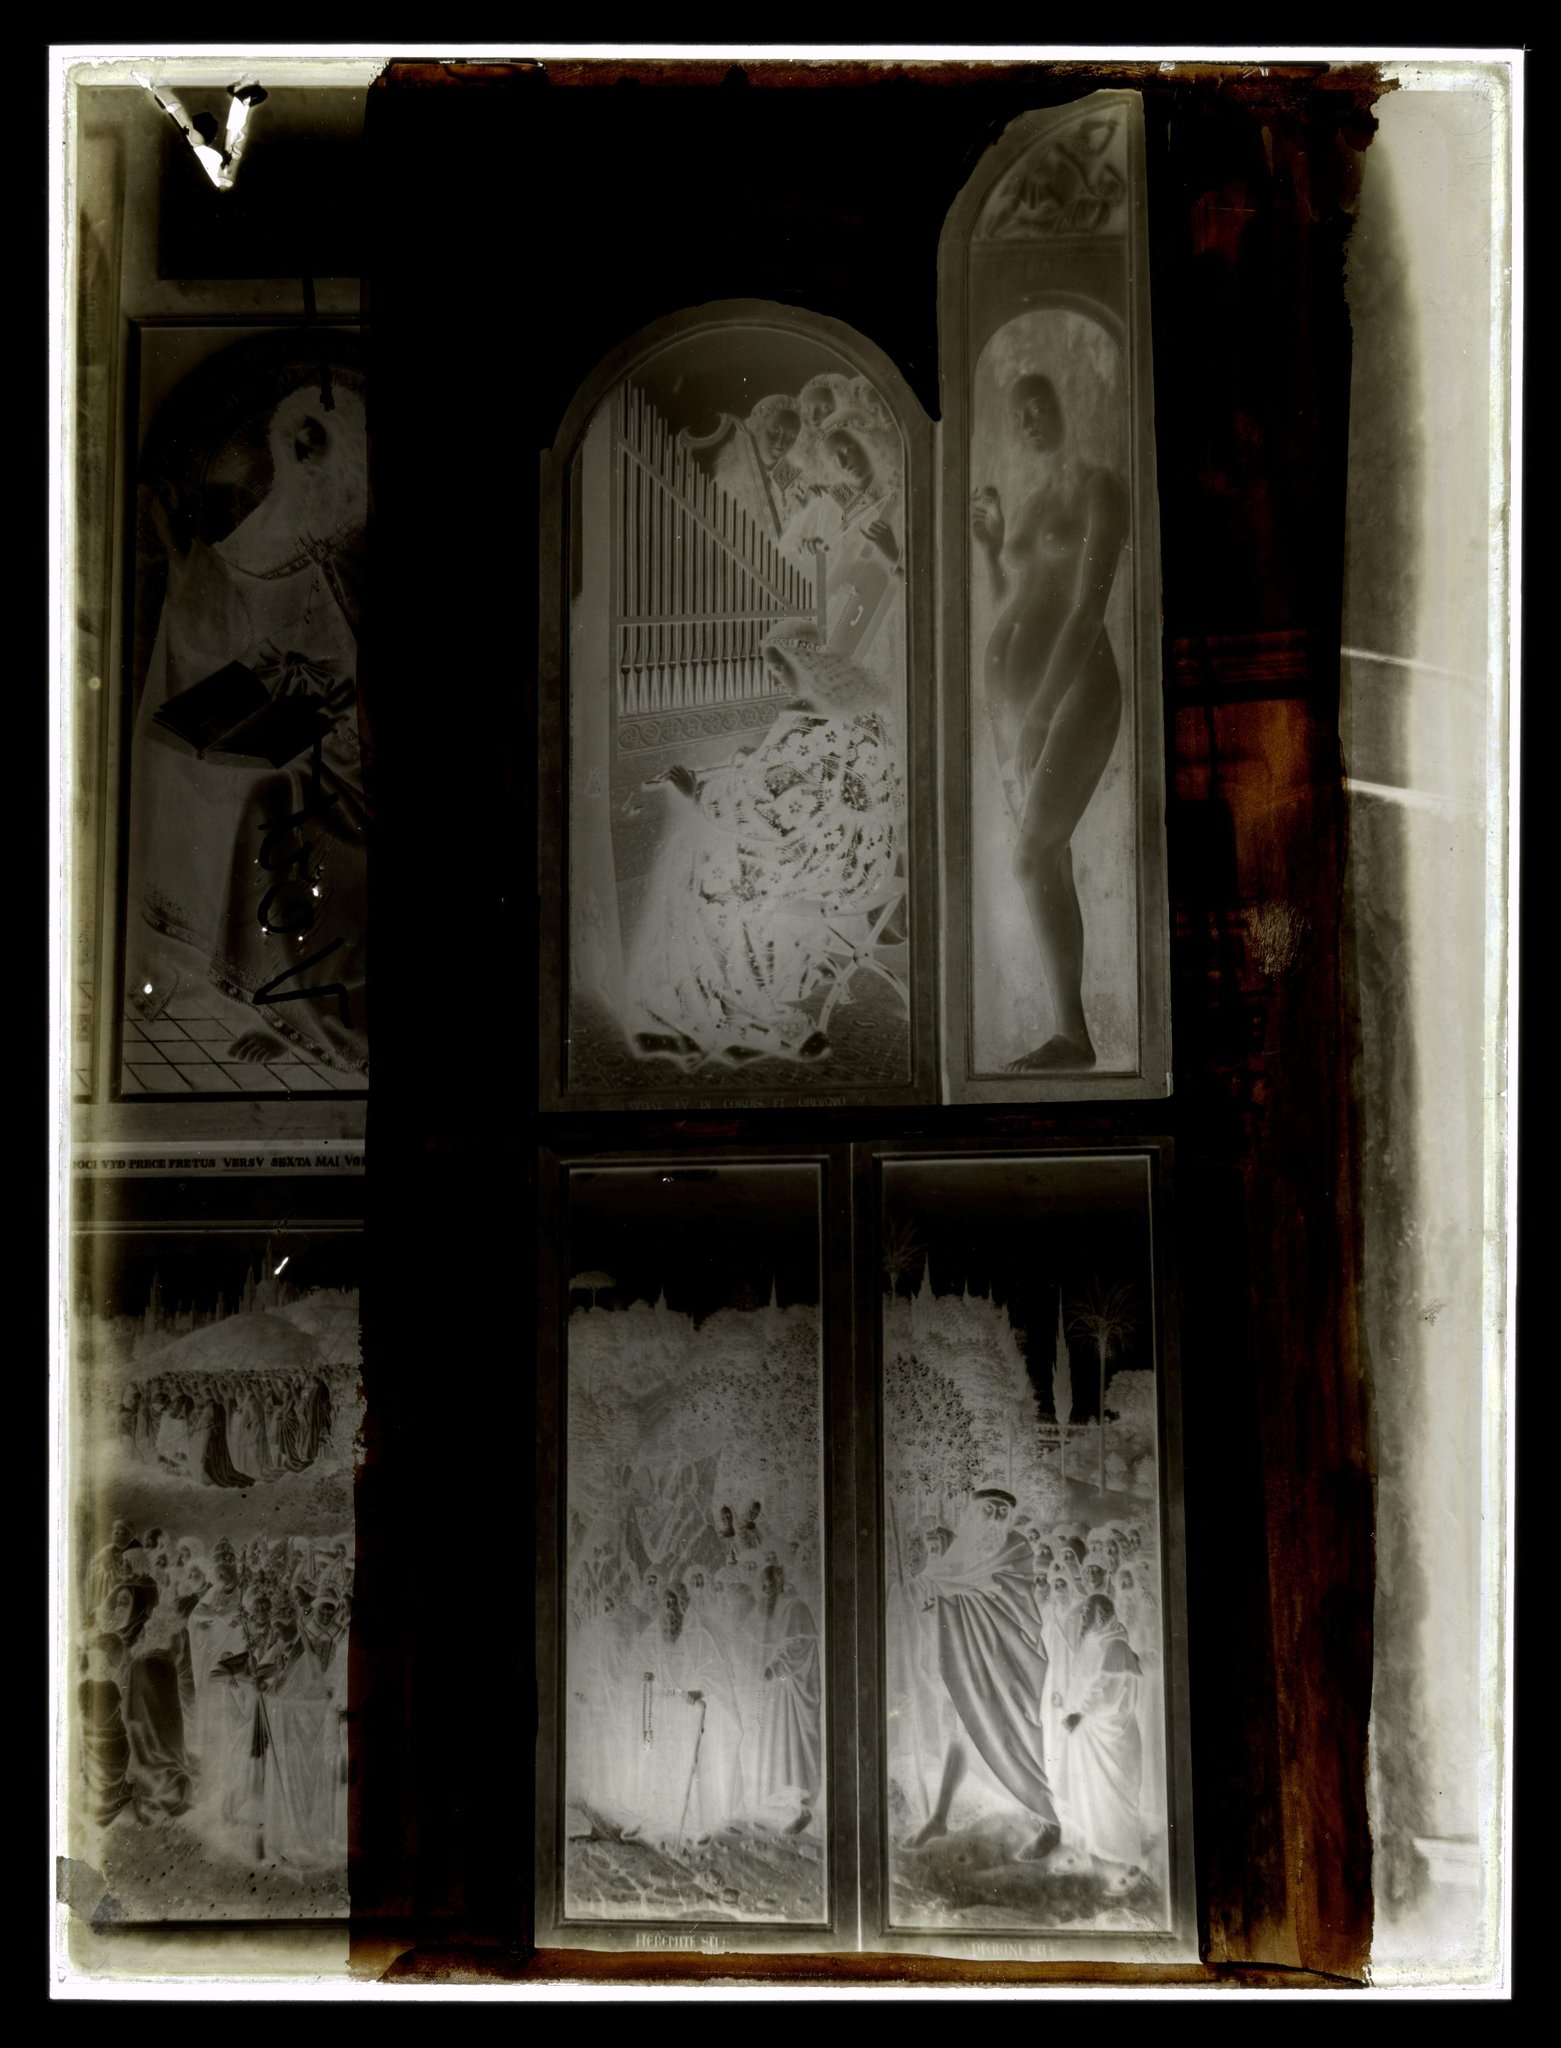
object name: photograph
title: Deelnegatief van het rechterpaneel van het altaarstuk De aanbidding van het Lam Gods door Hubert en Jan van Eyck, opgesteld in de Sint-Baafskathedraal, Gent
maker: Anonymous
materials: glass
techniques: gelatin silver negative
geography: ghent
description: Gefotografeerd door een rood-, groen- en blauwfilter.